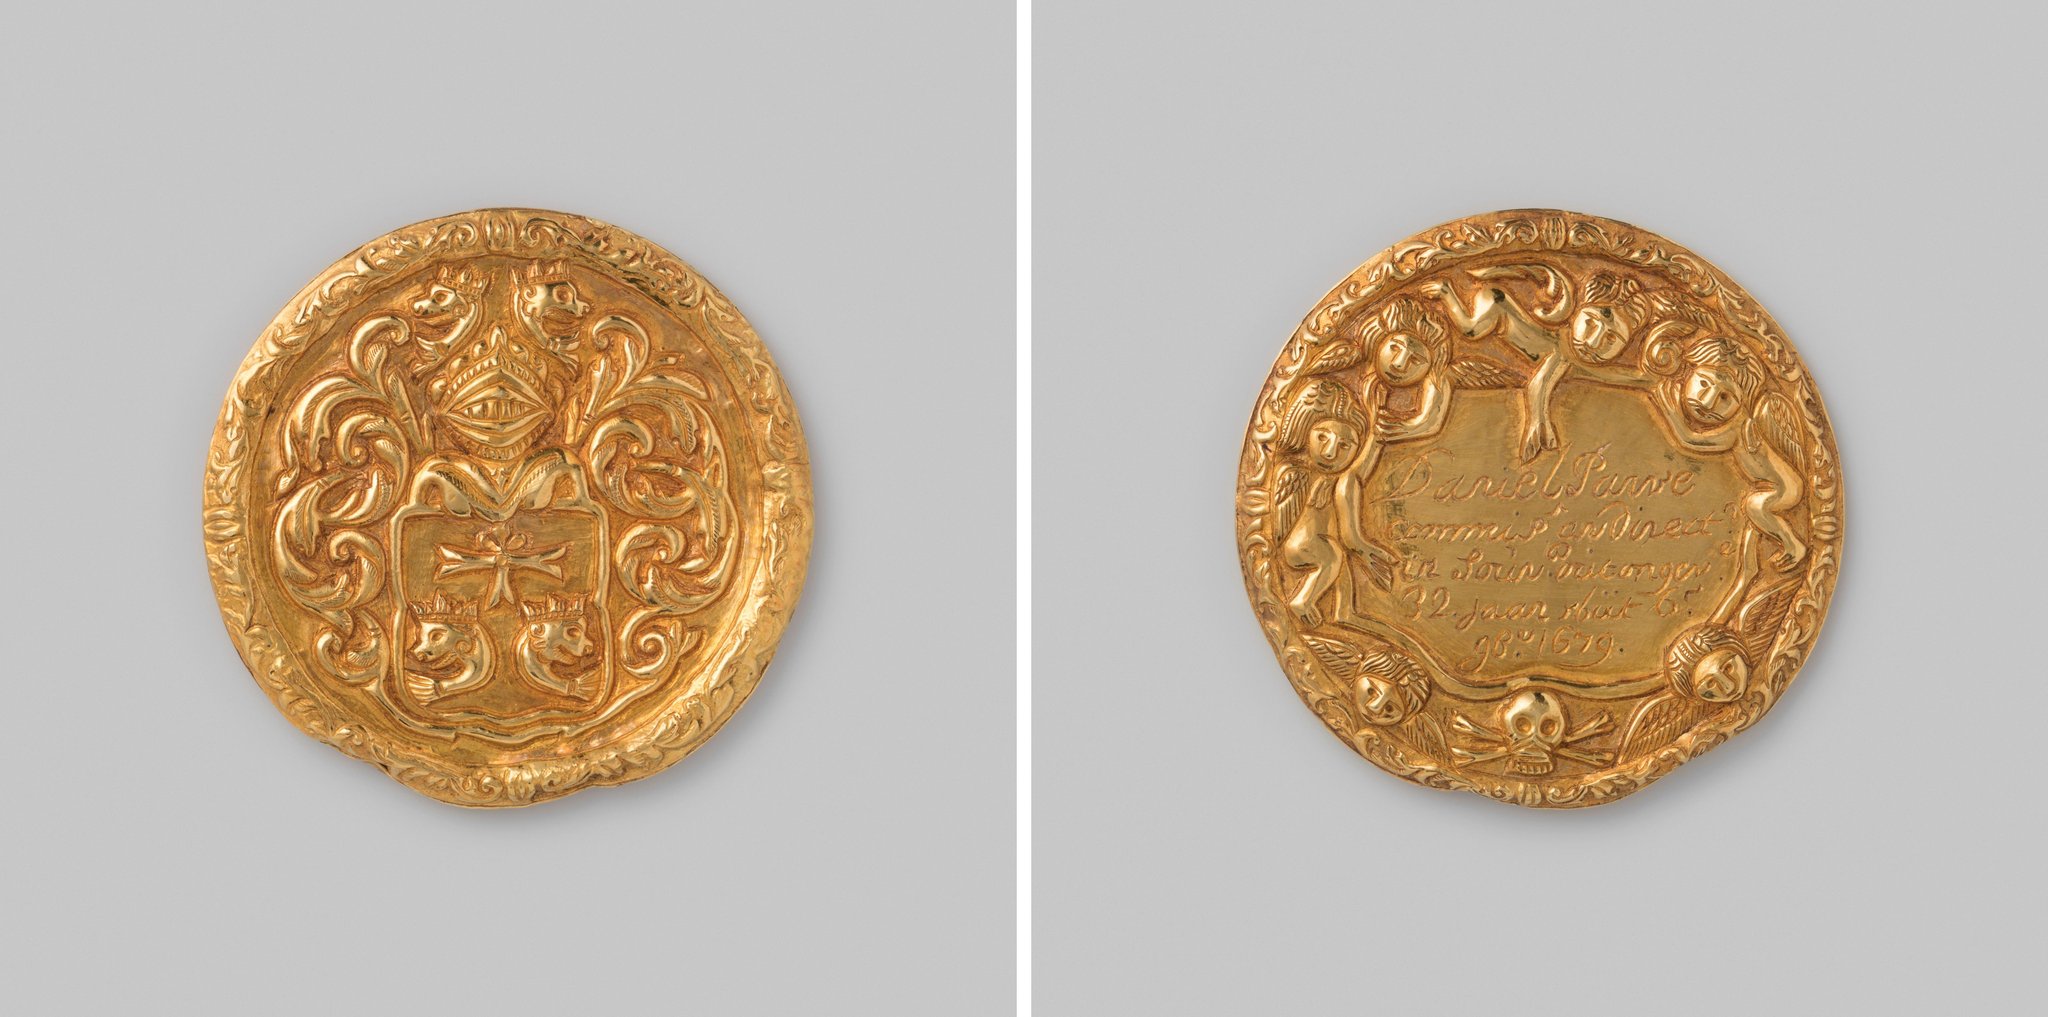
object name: overlijdenspenning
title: Penning ter nagedachtenis van Daniël Parvé (1644-1679)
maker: Anonymous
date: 1679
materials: gold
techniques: engraving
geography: surat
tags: rotterdam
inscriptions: inscription: ‘Daniel Parve commis.s au direct.r in Soura.out ongev.e 32 obiit 6e gb.e 1679’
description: Gedreven rood gouden penning. Voorzijde: Hugenotenkruis met daaronder 2 gekroonde zeepaardjes. (wapen familie Parvé). Hierboven een helm met daarboven 2 gekroonde zeepaardjes. Keerzijde: binnen rand met engelen (hoofd en vleugels) het opschrift. M.o. schedel met gekruiste beenderen.